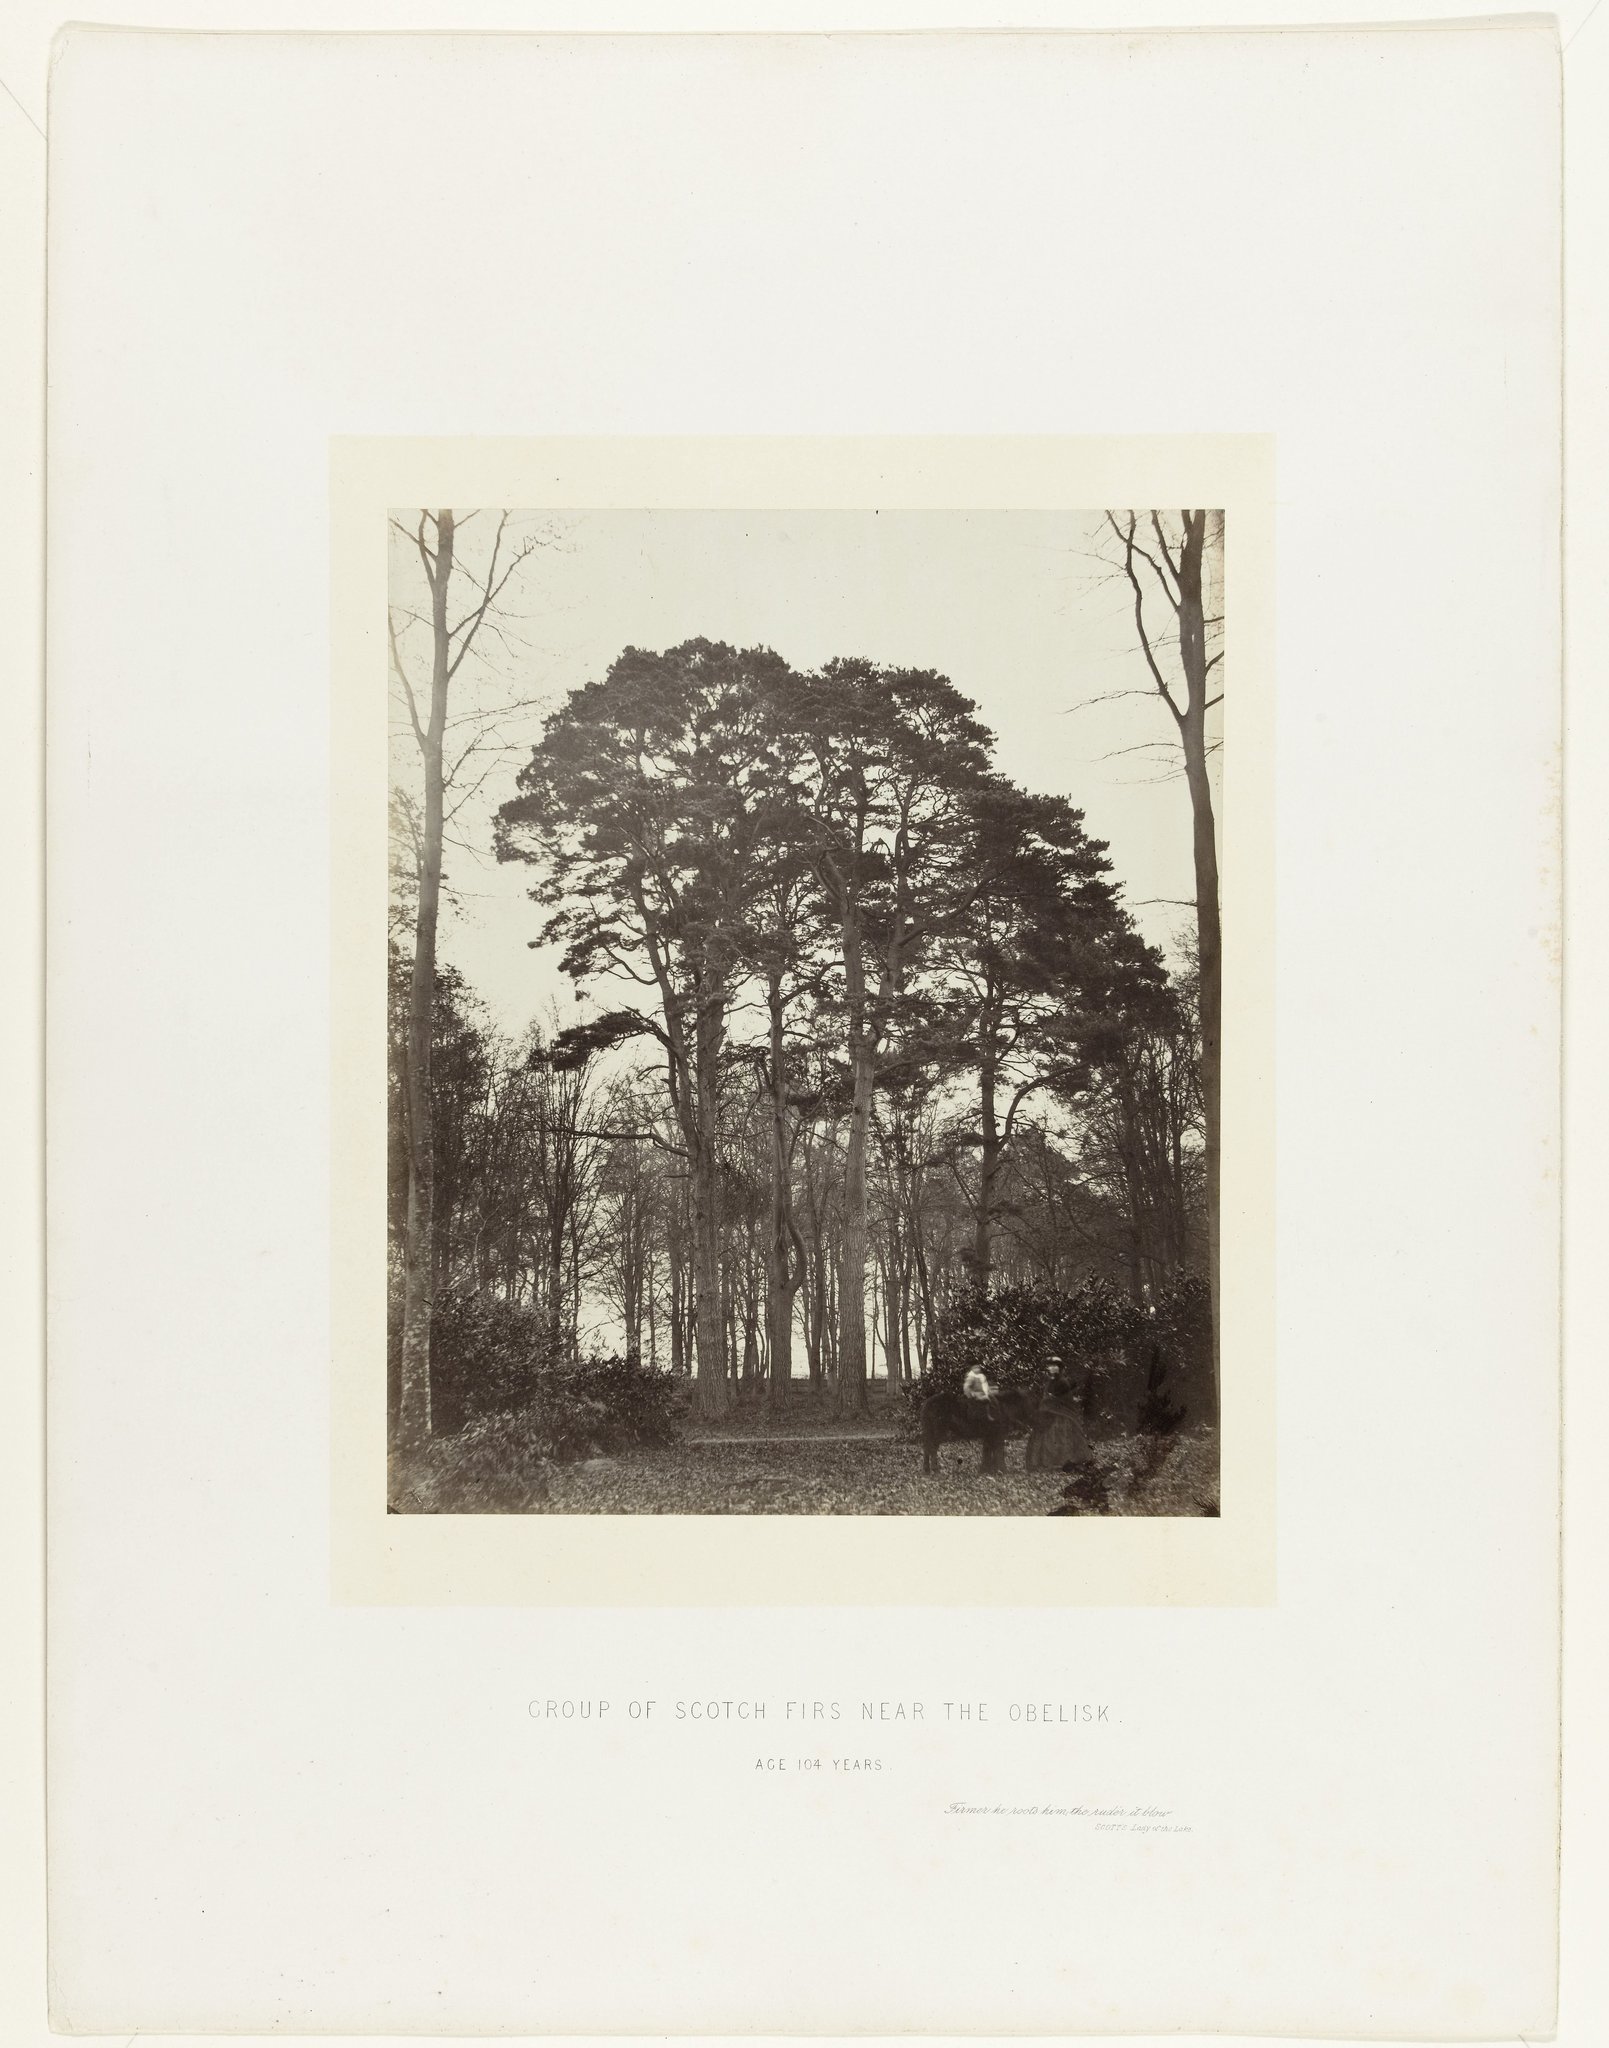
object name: photograph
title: Groep naaldbomen vlakbij de obelisk op Windsor Estate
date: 1854-1864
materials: paper, photographic support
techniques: albumen print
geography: great britain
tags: windsor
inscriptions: inscription: ‘Firmer he roots him the ruder it blow/ Scott's Lady of the Lake.’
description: Groep naaldbomen vlakbij de obelisk op Windsor Estate. Rechts op de voorgrond een vrouw bij een kind op een pony. De foto is uitgegeven als plaat 10 in het boek The History of Windsor Great Park and Windsor Forest.